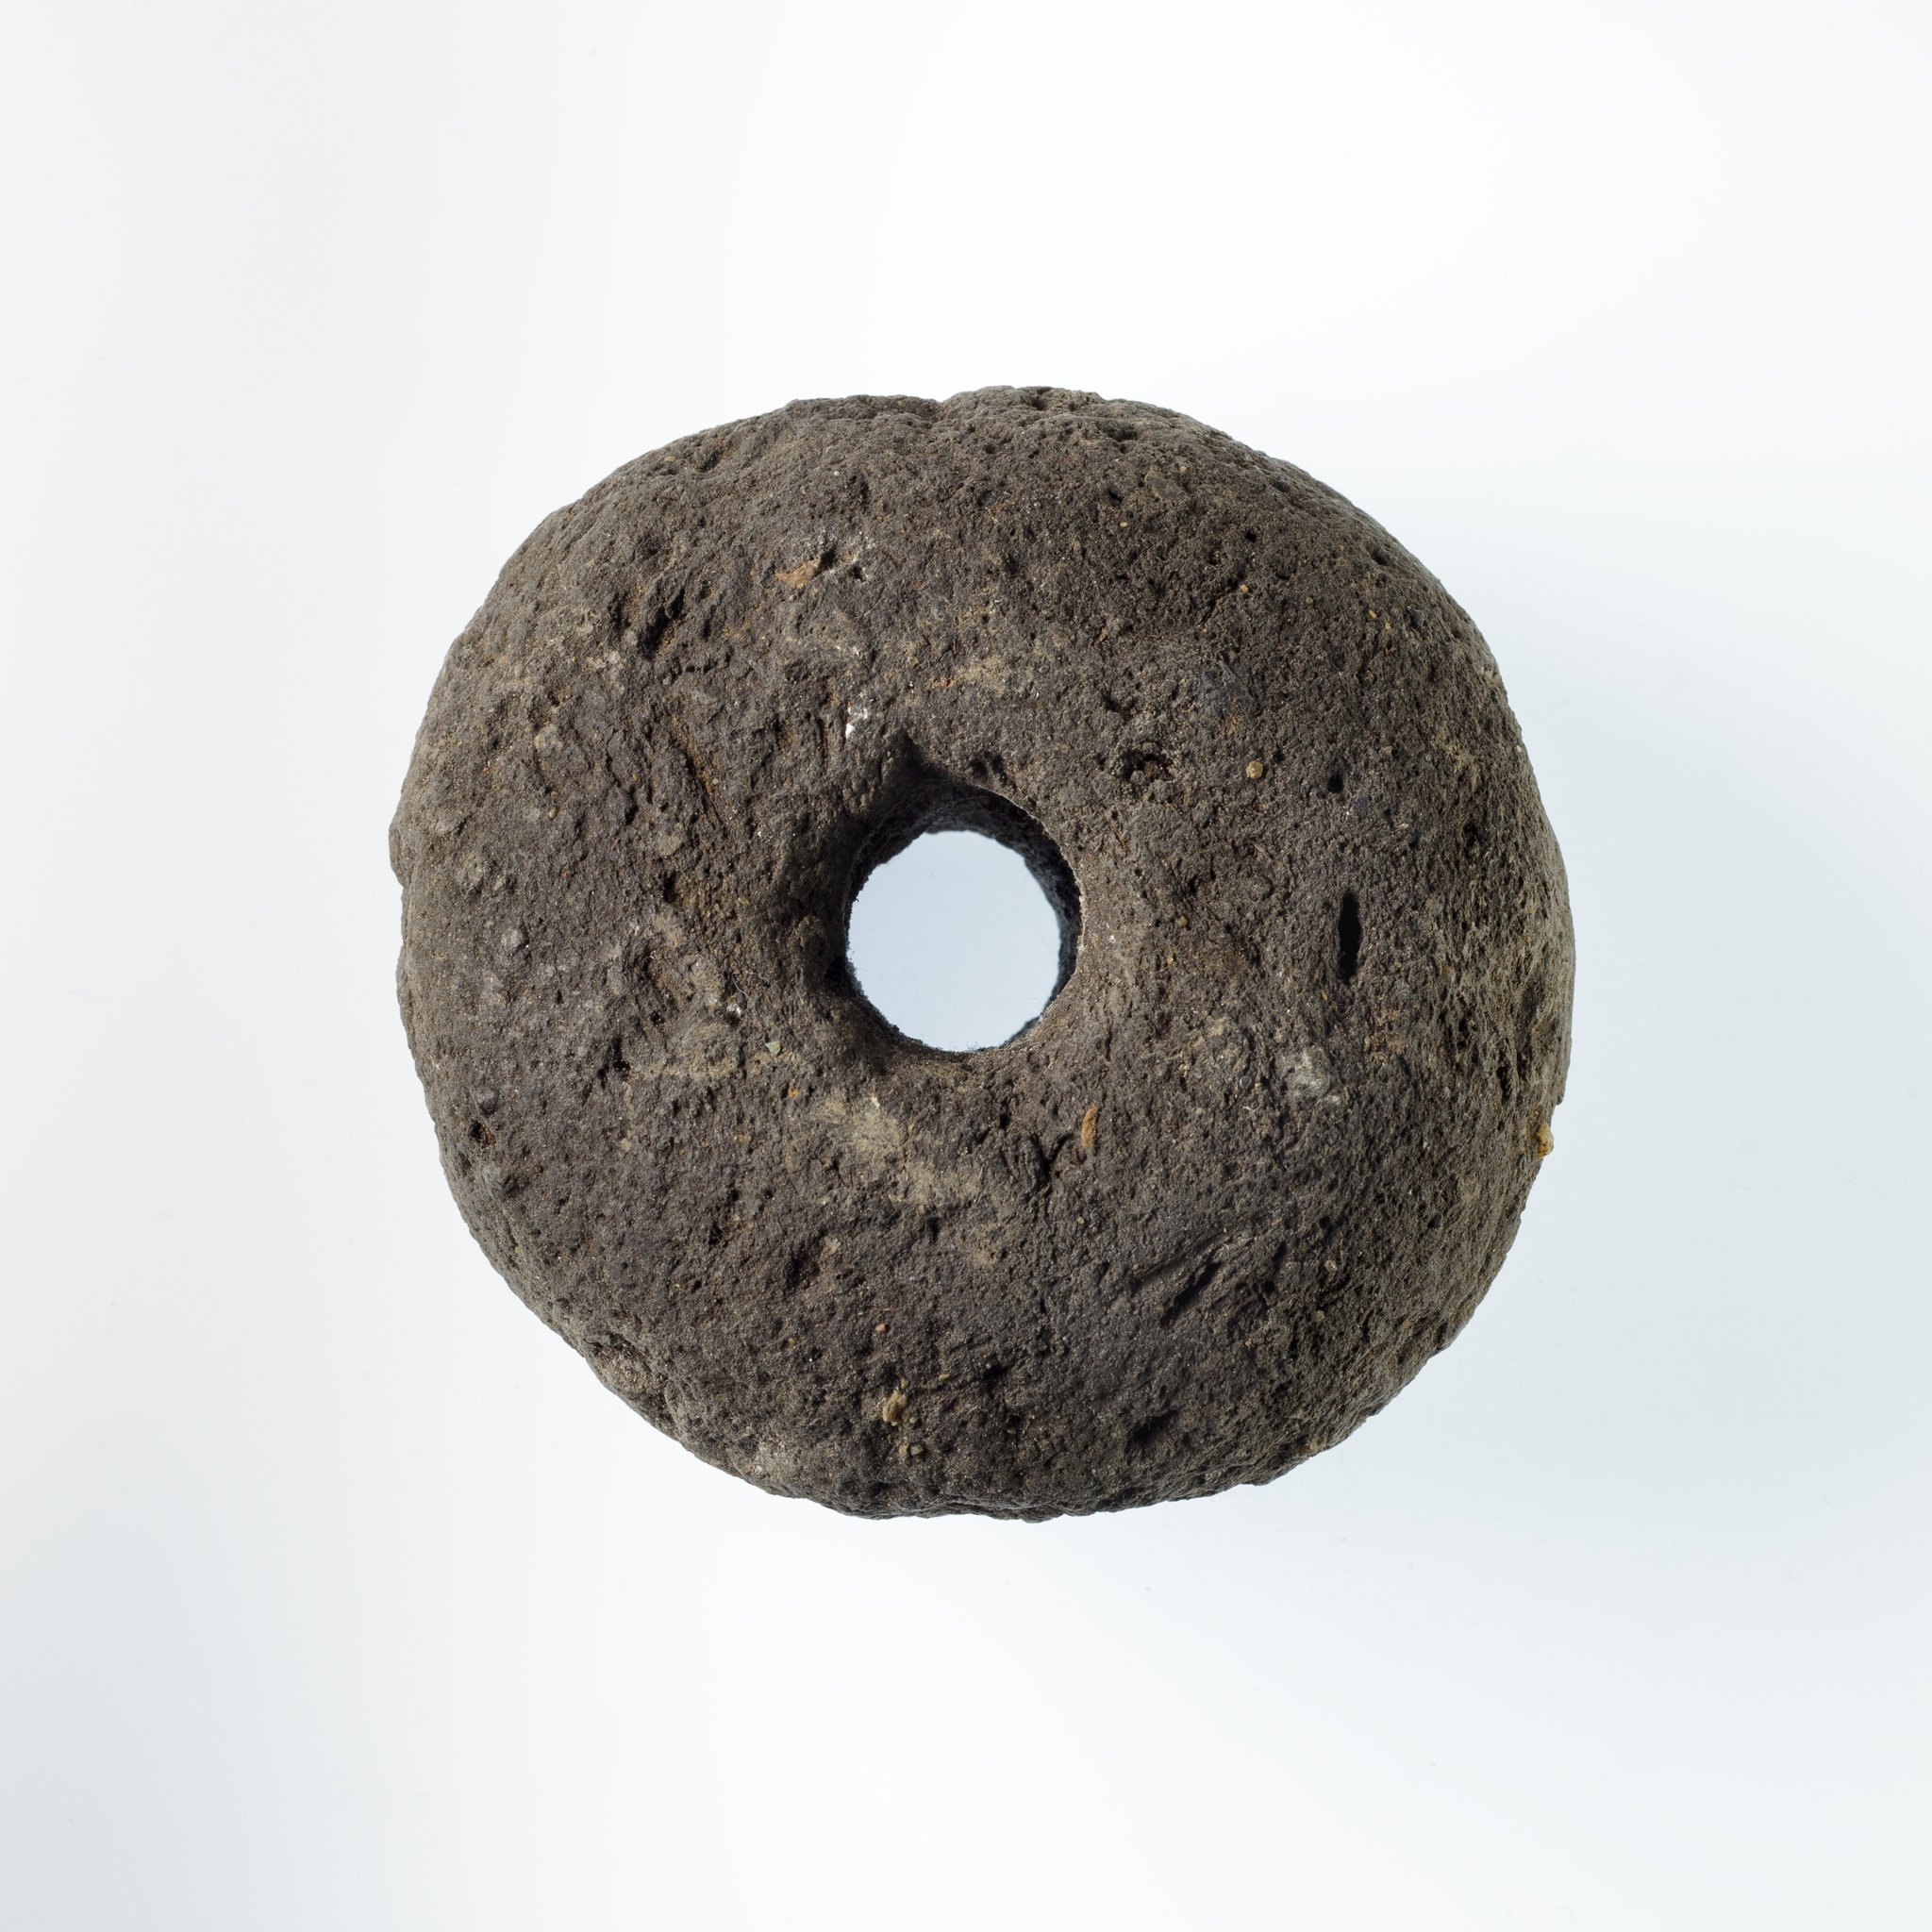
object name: loom weight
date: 1295-1070 BCE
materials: mud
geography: egypt